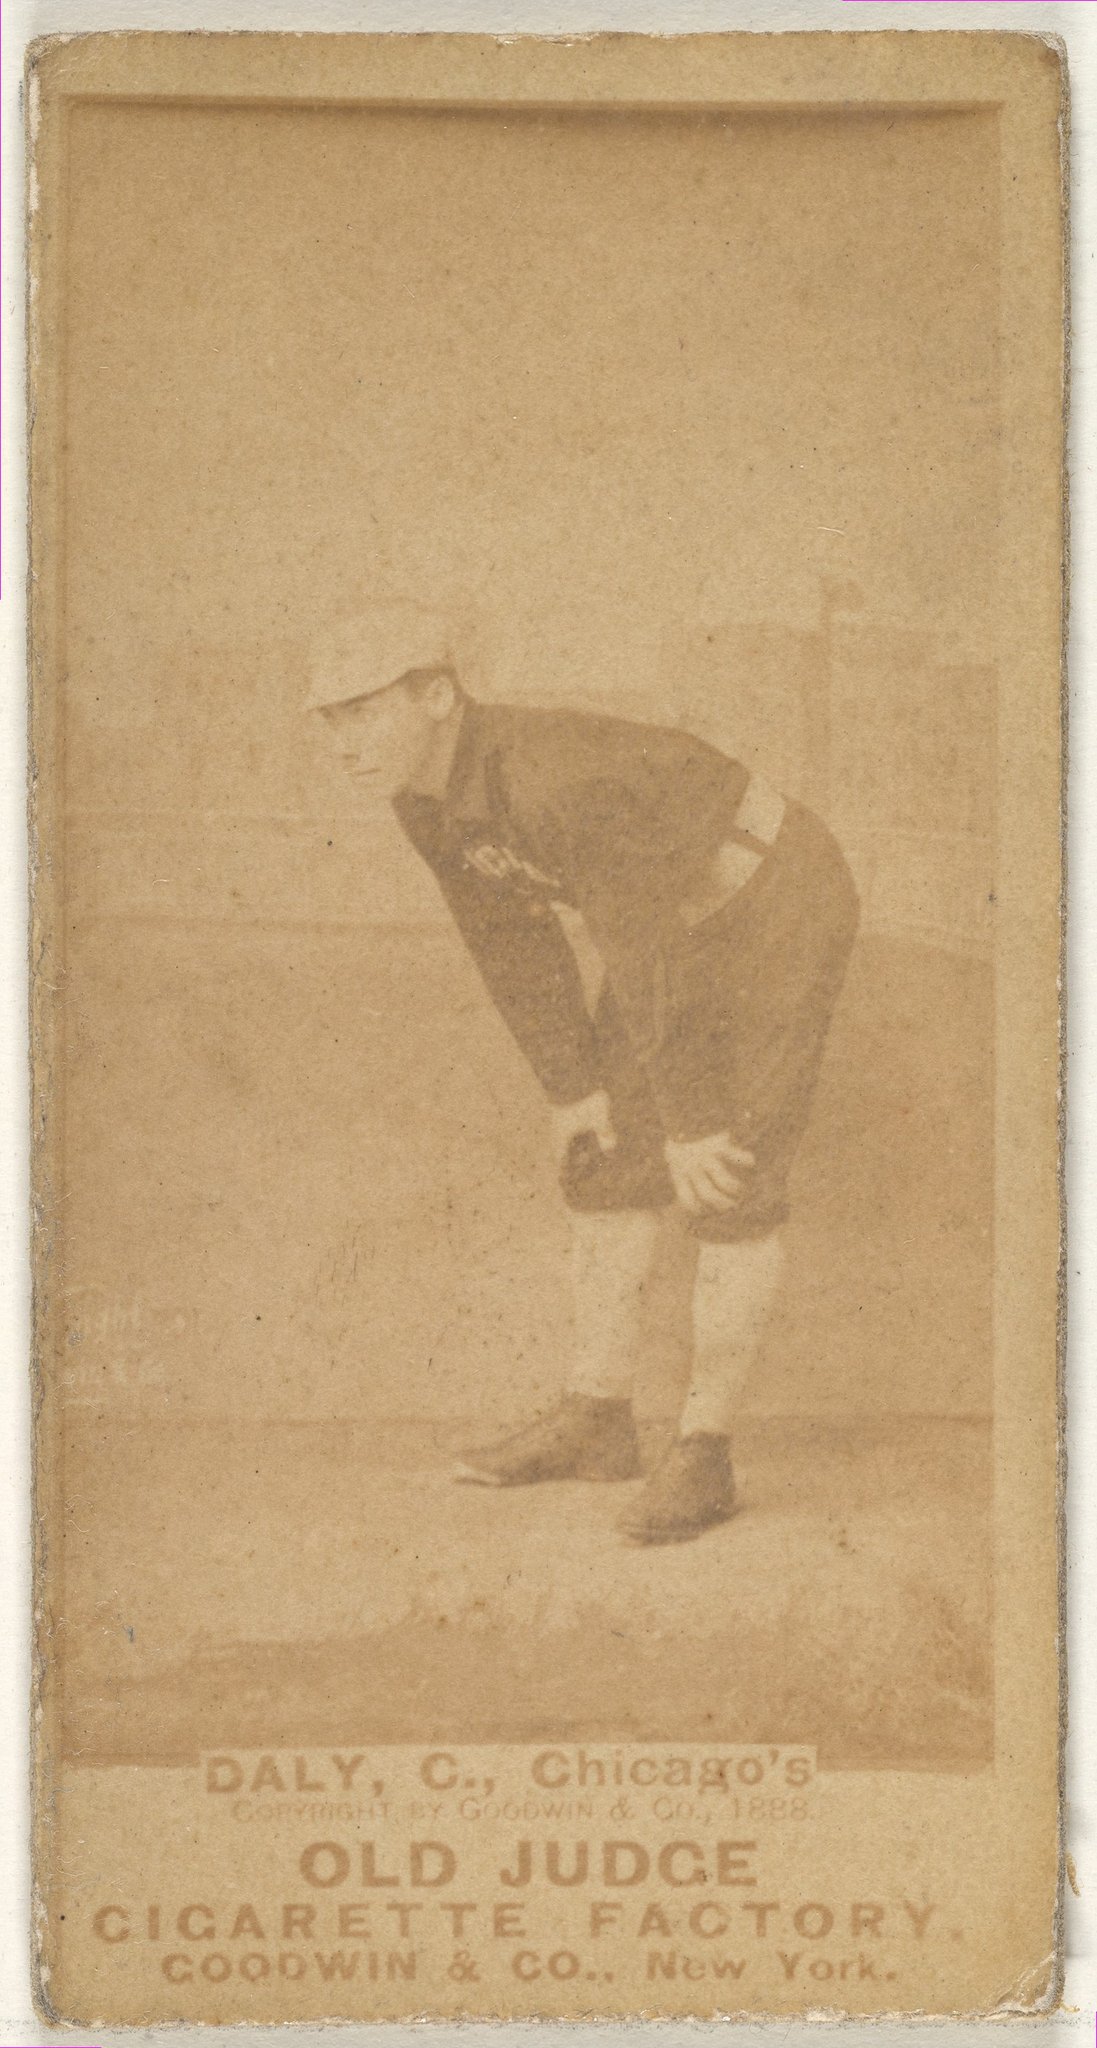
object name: baseball card, photograph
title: Daly, Catcher, Chicago, from the Old Judge series (N172) for Old Judge Cigarettes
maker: goodwin & company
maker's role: publisher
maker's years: 1850-1950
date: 1888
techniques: albumen silver print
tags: men,portraits,baseball,athletes